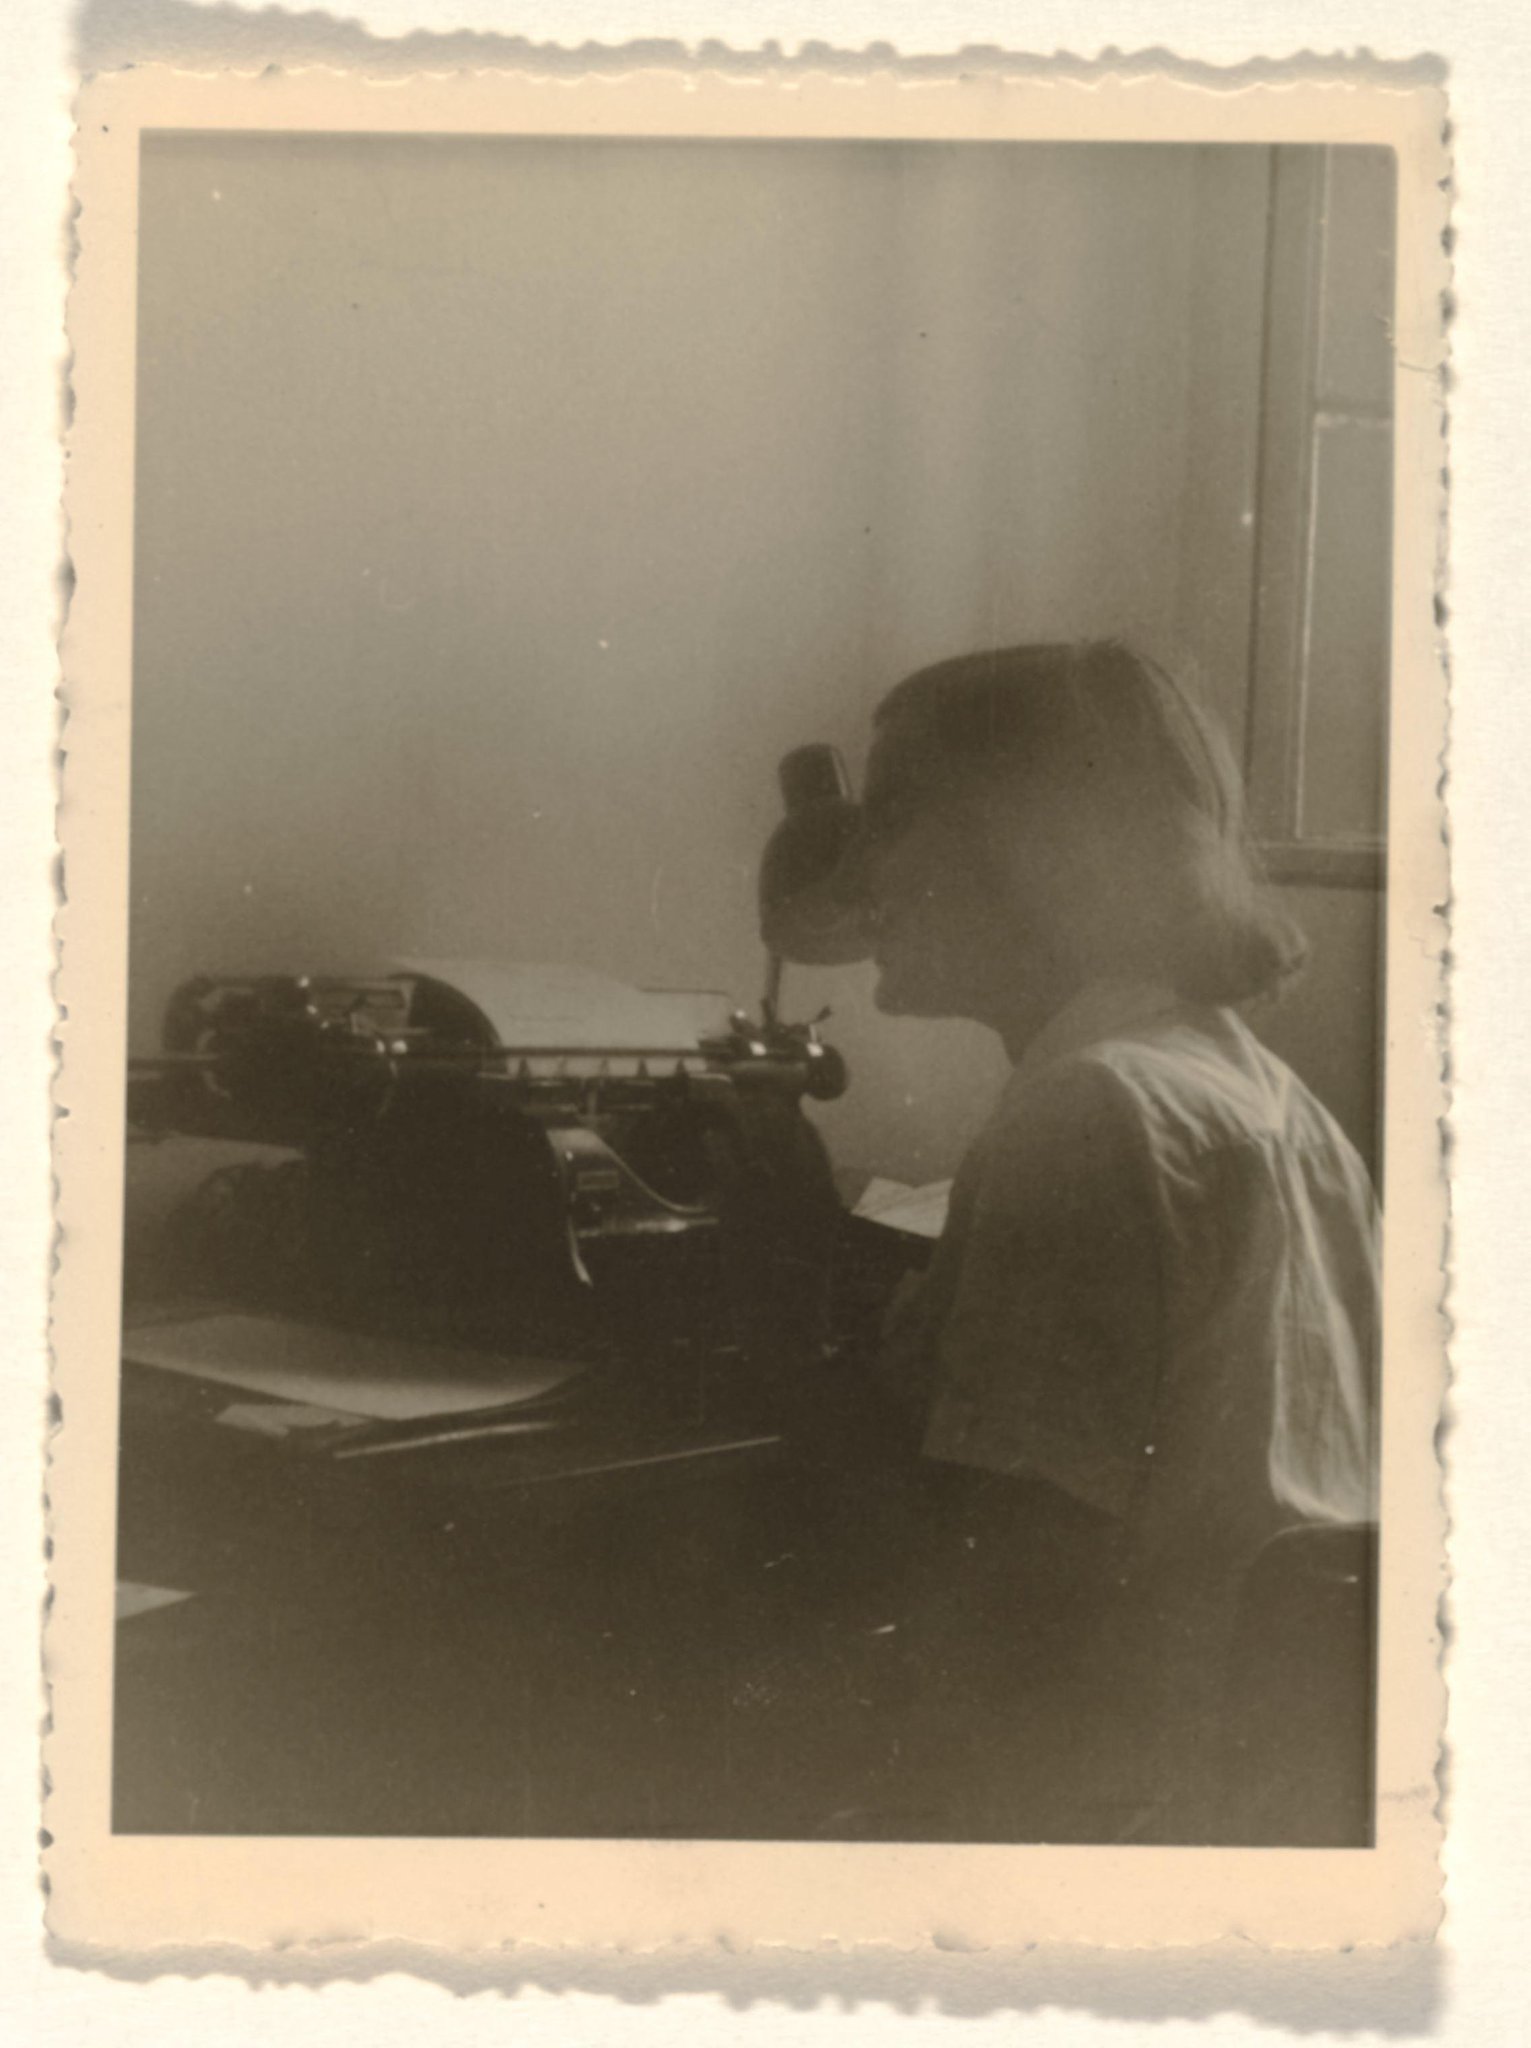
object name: photograph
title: Isabel Wachenheimer gezeten achter een schrijfmachine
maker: Anonymous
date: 1945-1963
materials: photographic support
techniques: gelatin silver print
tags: isabel wachenheimer-elon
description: Isabel Wachenheimer in licht hemd gezeten achter een schrijfmachine.